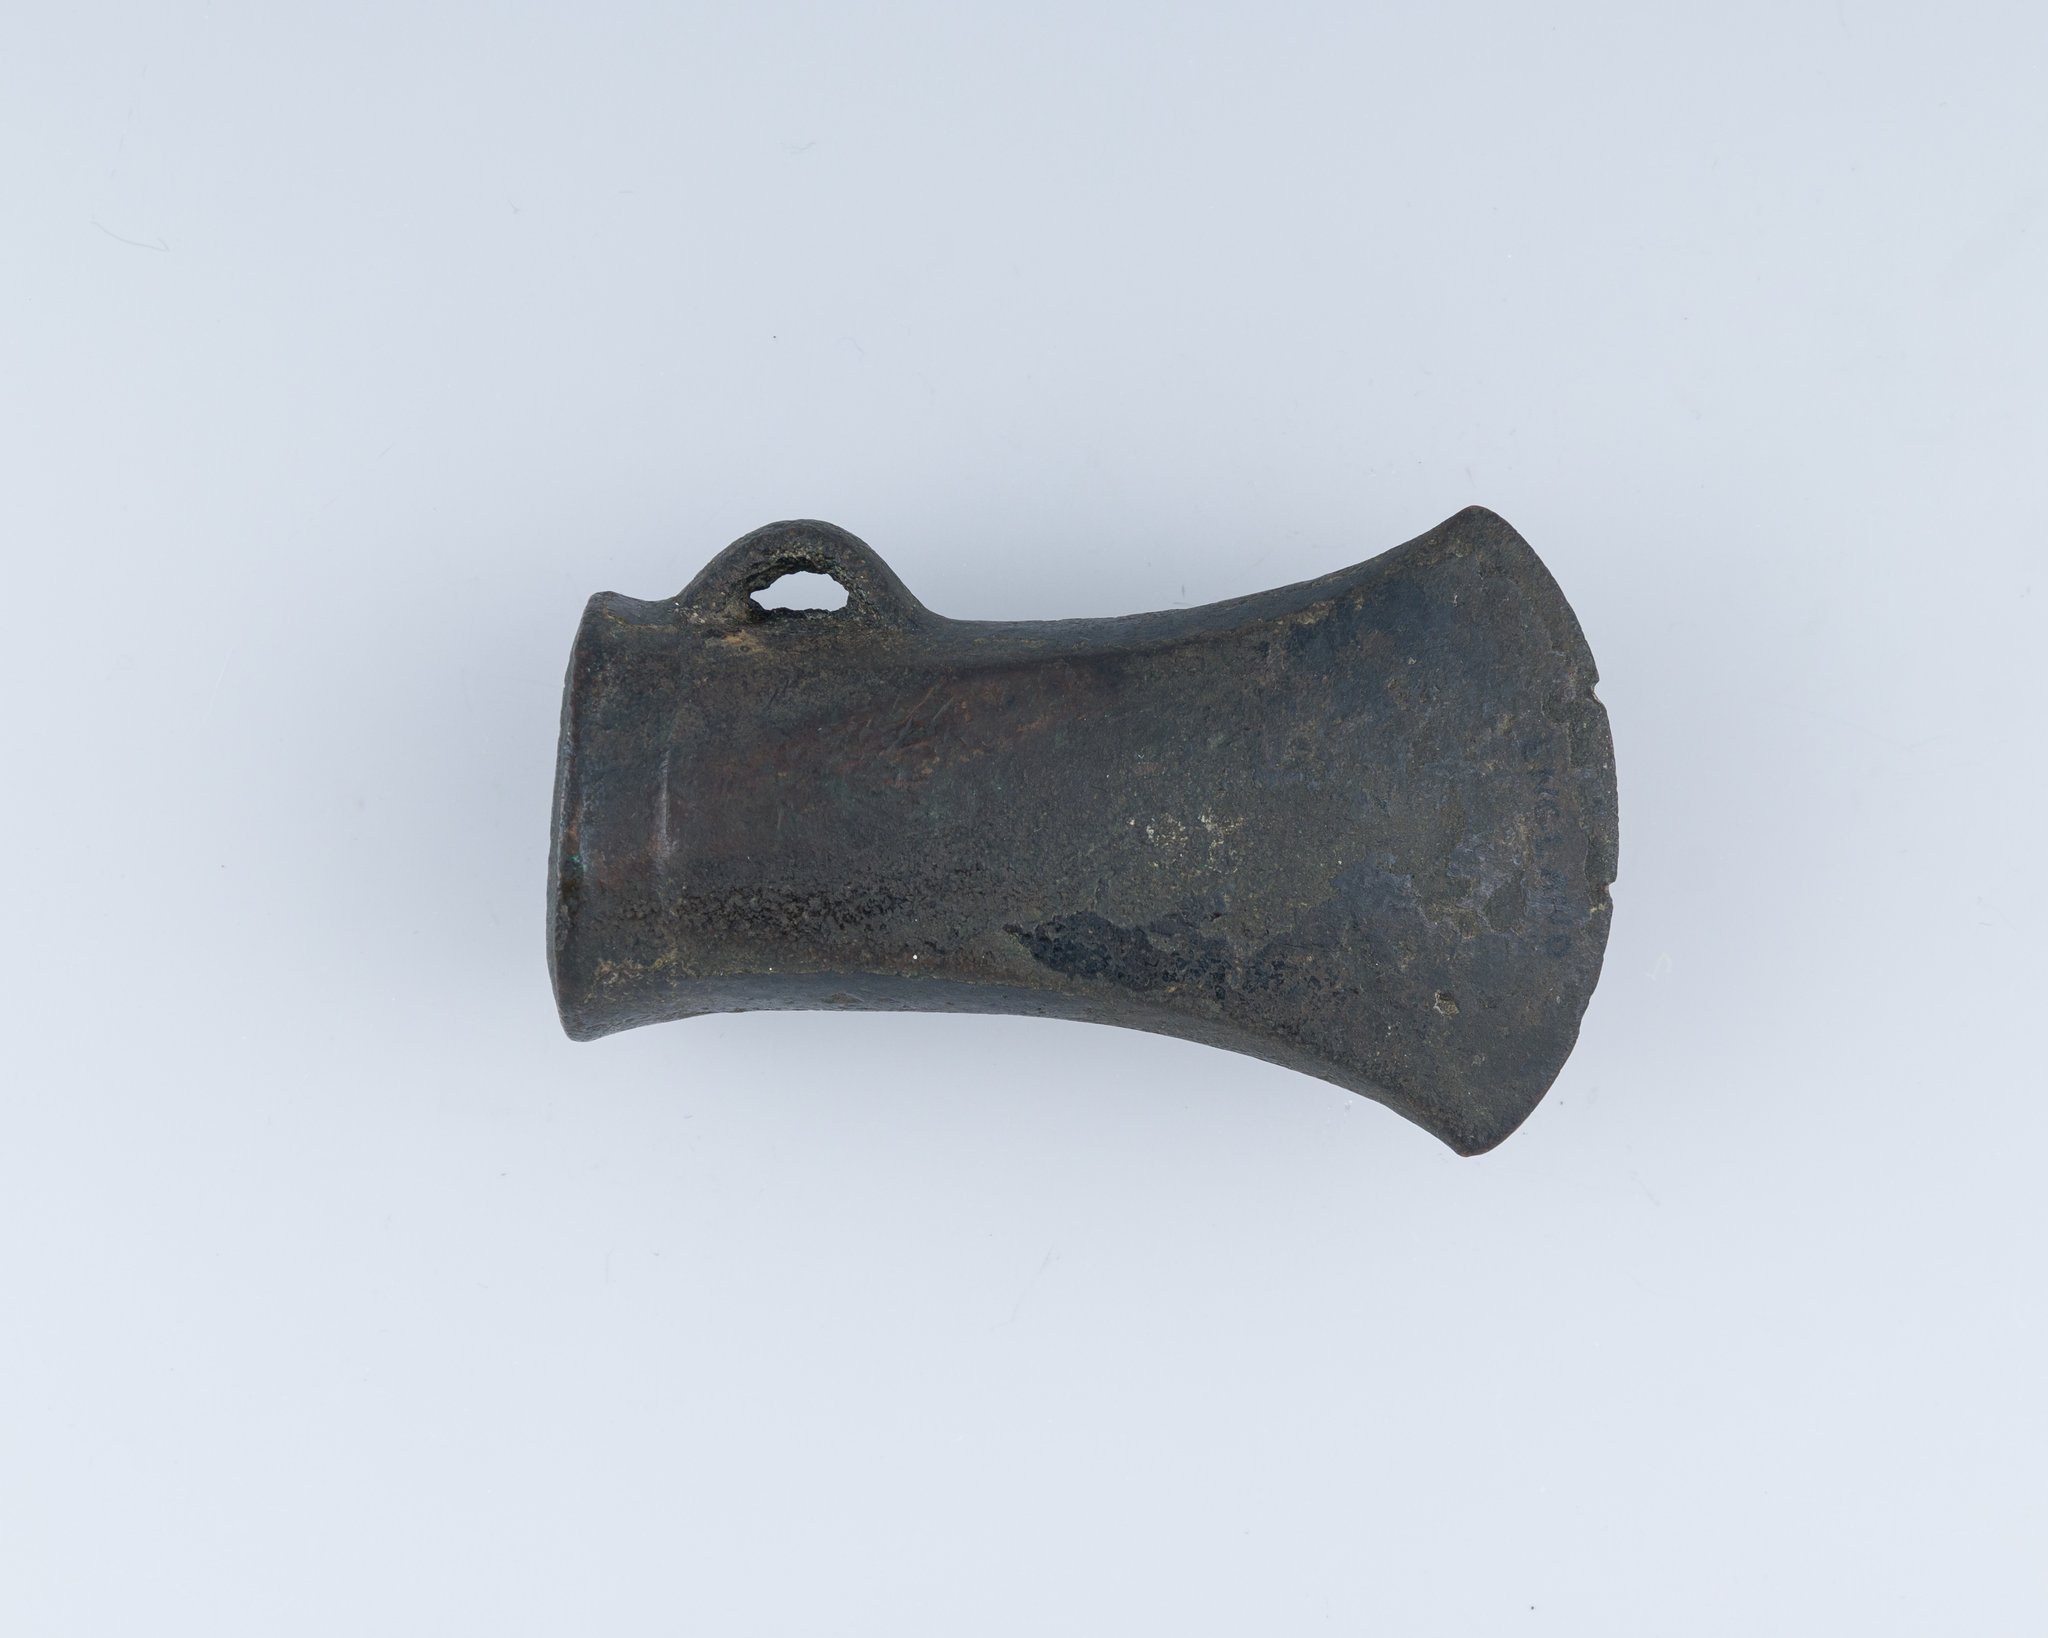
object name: socketed ax head celt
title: Socketed Ax-Head (Celt)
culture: british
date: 900 BCE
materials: bronze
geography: england